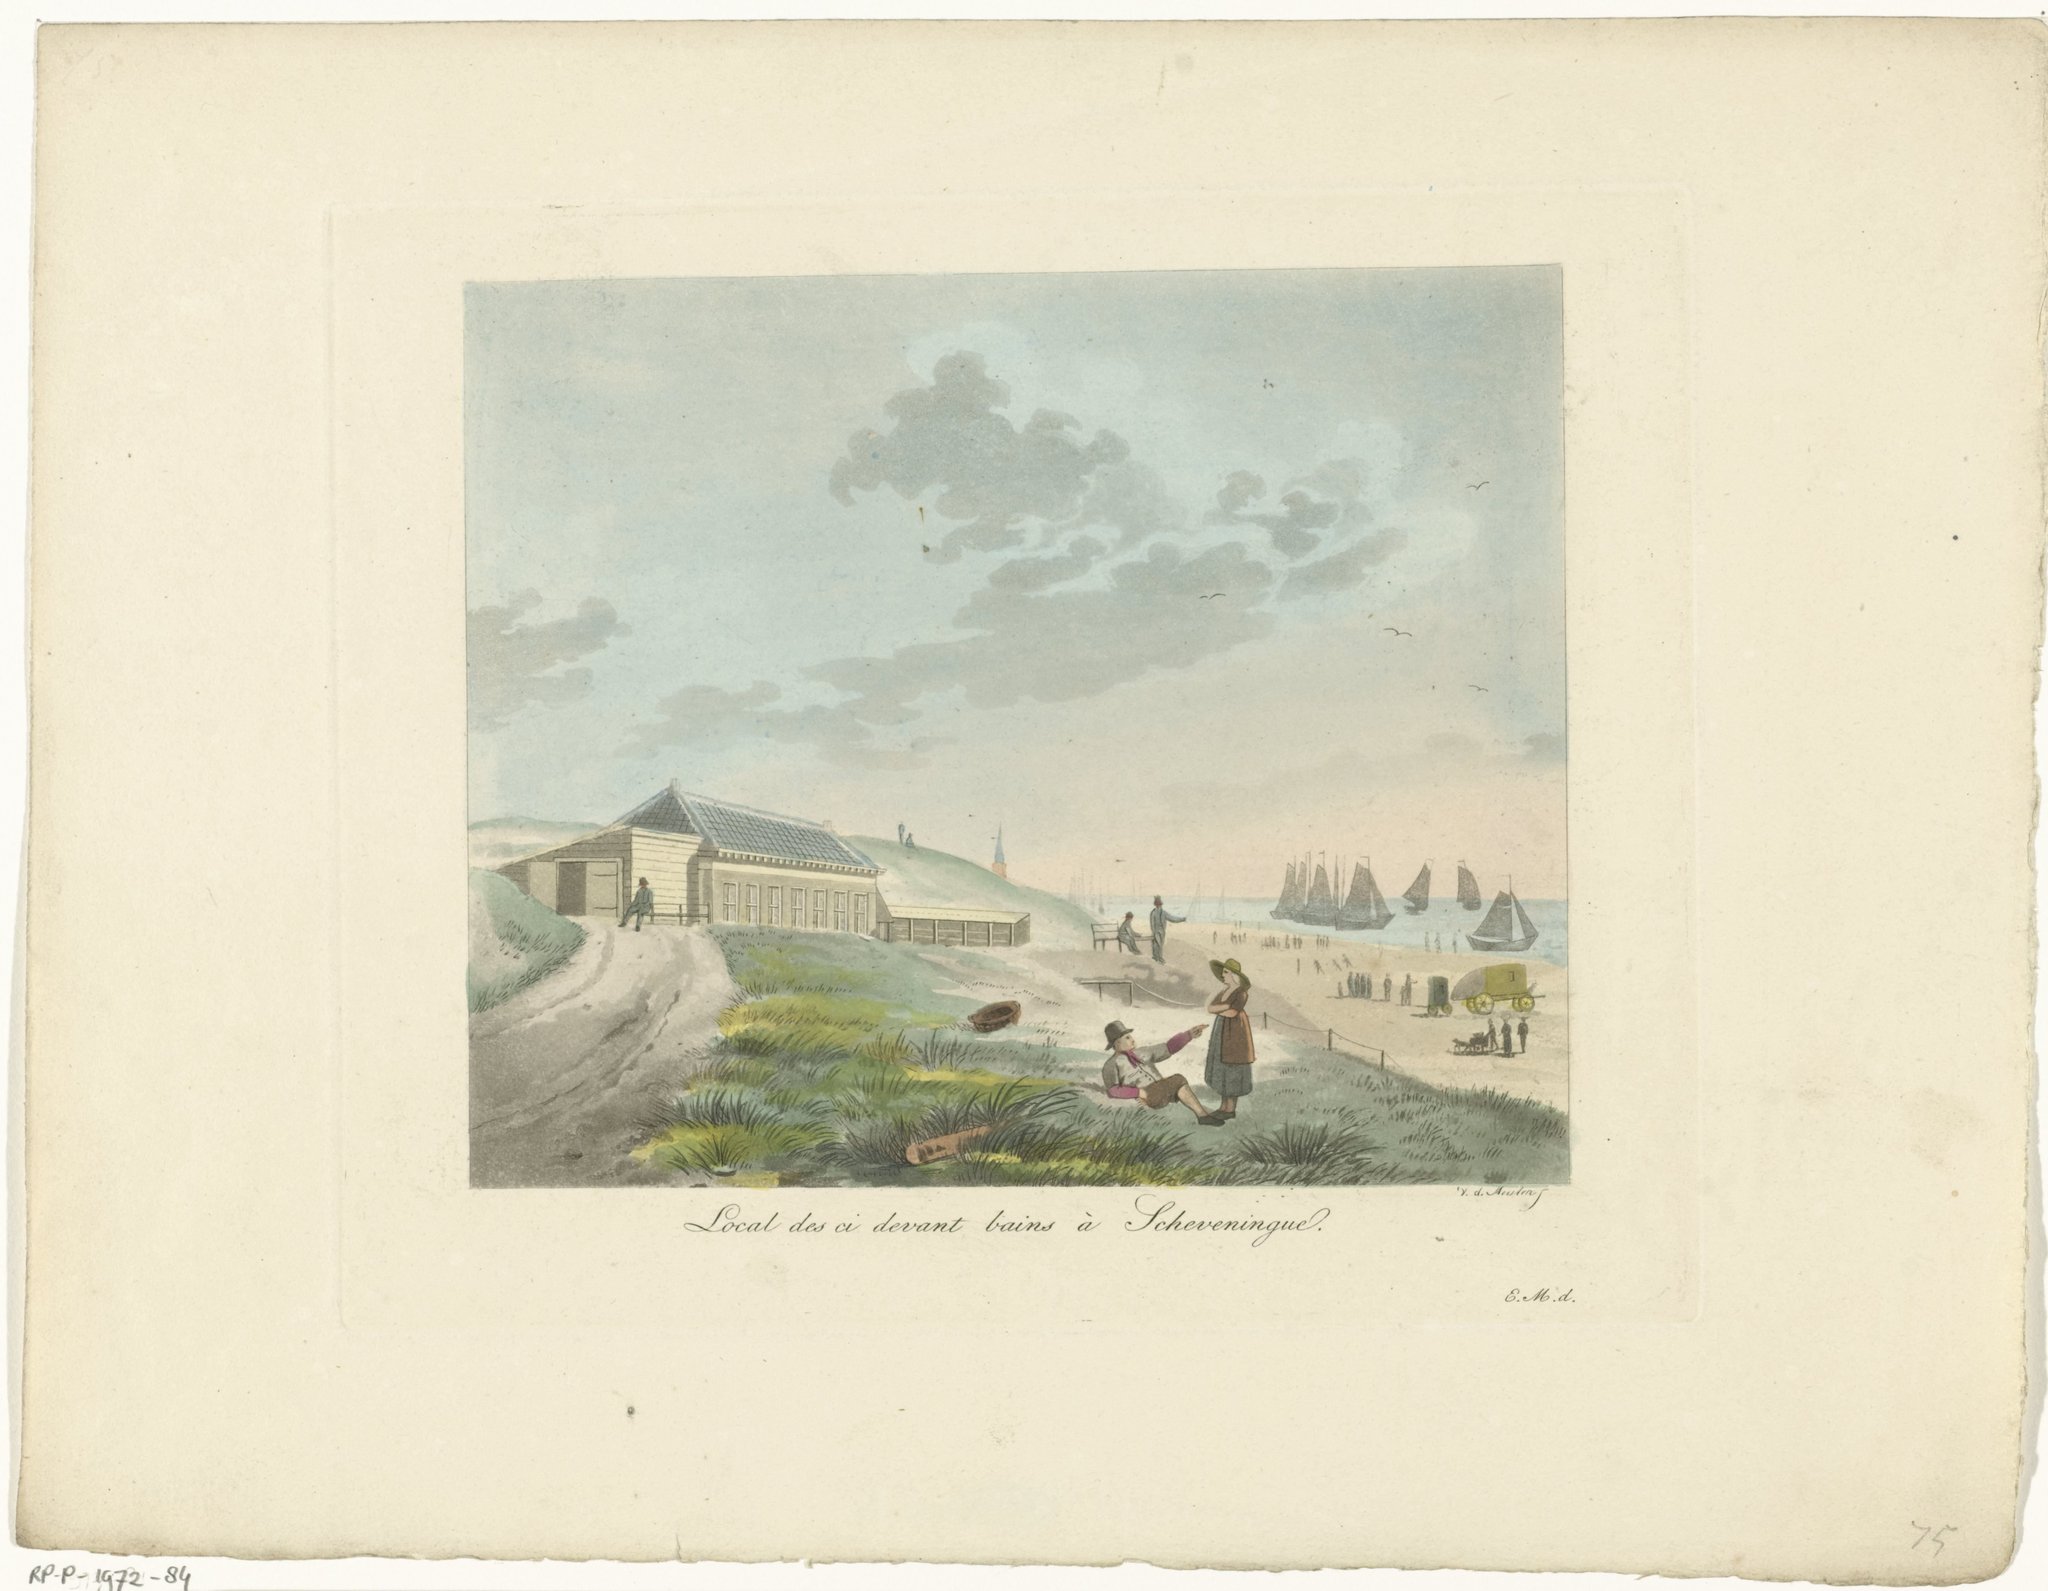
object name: print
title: Local des ci devant bains à Scheveningen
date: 1816-1833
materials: paper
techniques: aquatint, etching, hand coloring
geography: amsterdam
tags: beach, dune coast (+ landscape with figures, staffage)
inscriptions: collector's mark: Lugt 2228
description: Prent ook gebruikt in: Maaskamp, Evert. Tableau des principales vues des palais et édifices : représentations et des coutumes et usages, dans les provinces septentrionales du Royaume des Pays-Bas. Amsterdam, Evert Maaskamp, 1824.